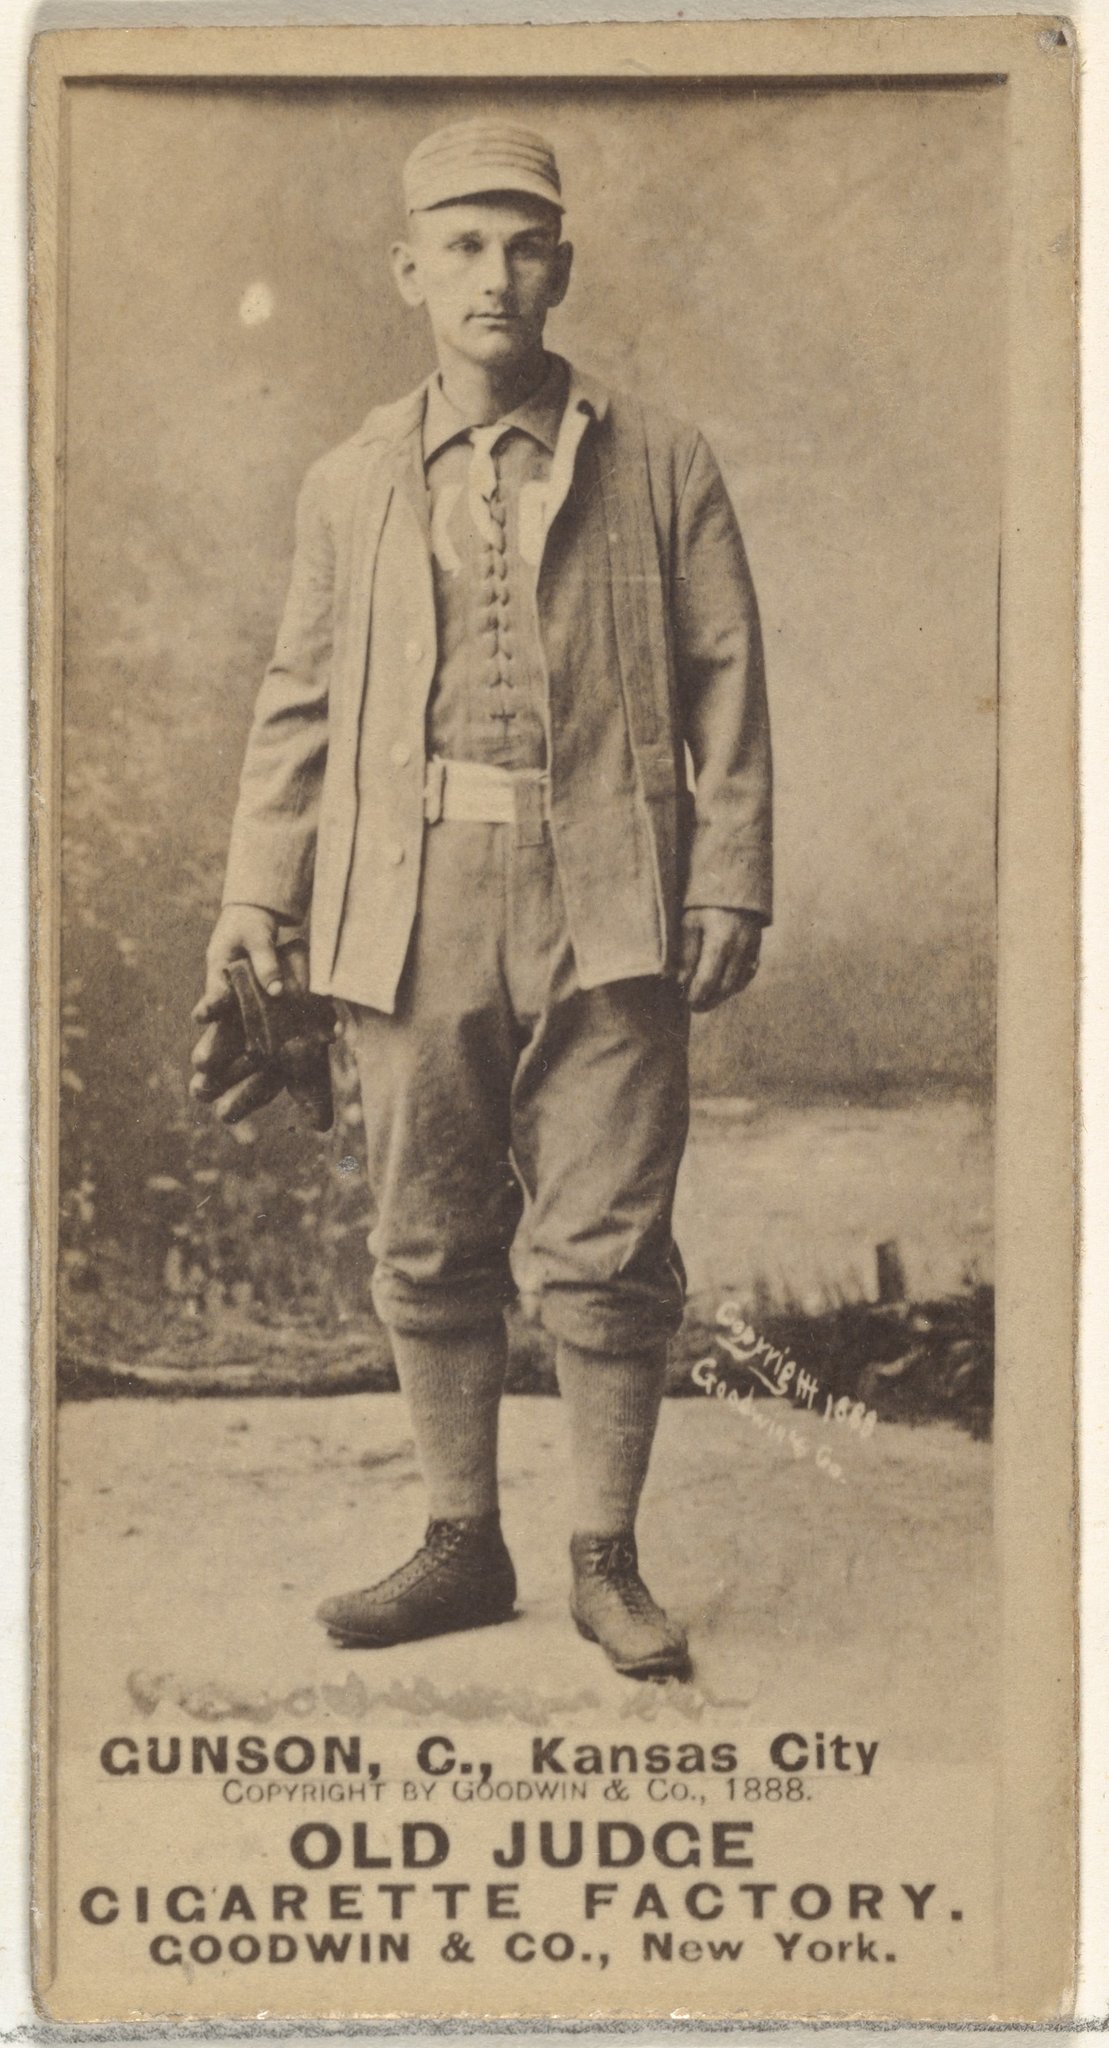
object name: baseball card, photograph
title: Joseph Brook "Joe" Gunson, Catcher, Kansas City Cowboys, from the Old Judge series (N172) for Old Judge Cigarettes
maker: goodwin & company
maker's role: publisher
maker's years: 1850-1950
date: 1888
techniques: albumen silver print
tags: men,portraits,baseball,athletes